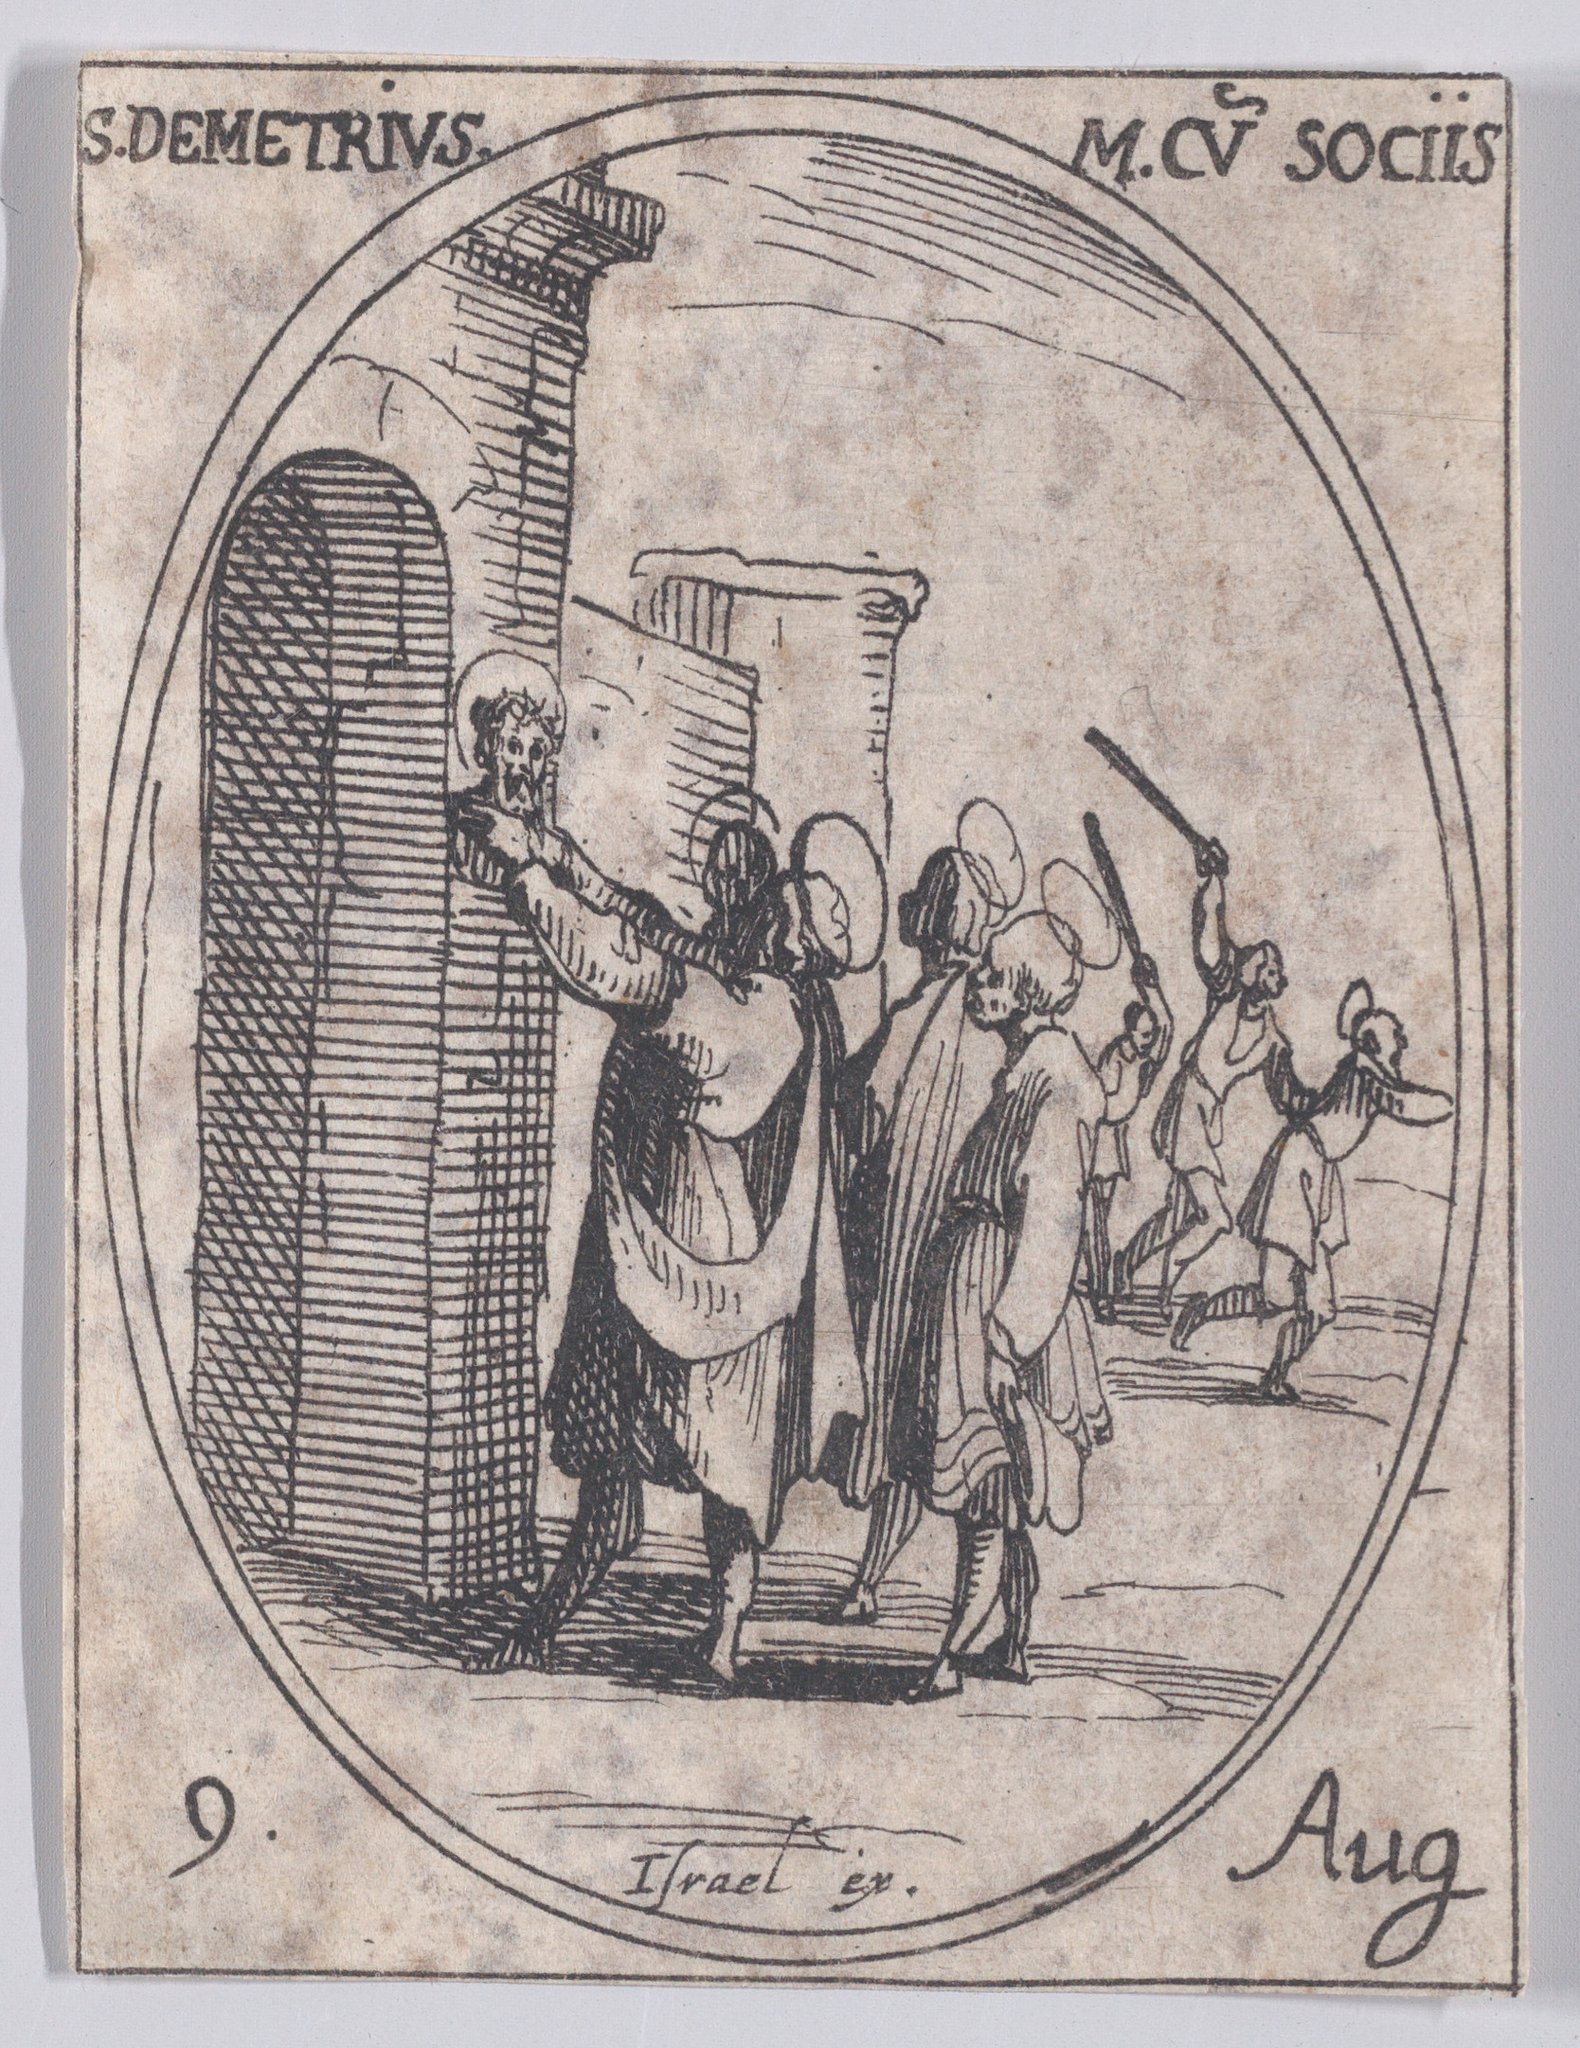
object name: print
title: S. Demetrius et Ses Compagnons (St. Demetrius and His Companions), August 9th, from "Les Images De Tous Les Saincts et Saintes de L'Année" (Images of All of the Saints and Religious Events of the Year)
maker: jacques callot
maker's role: artist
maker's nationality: french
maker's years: 1592-1635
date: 1636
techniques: etching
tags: men,saints